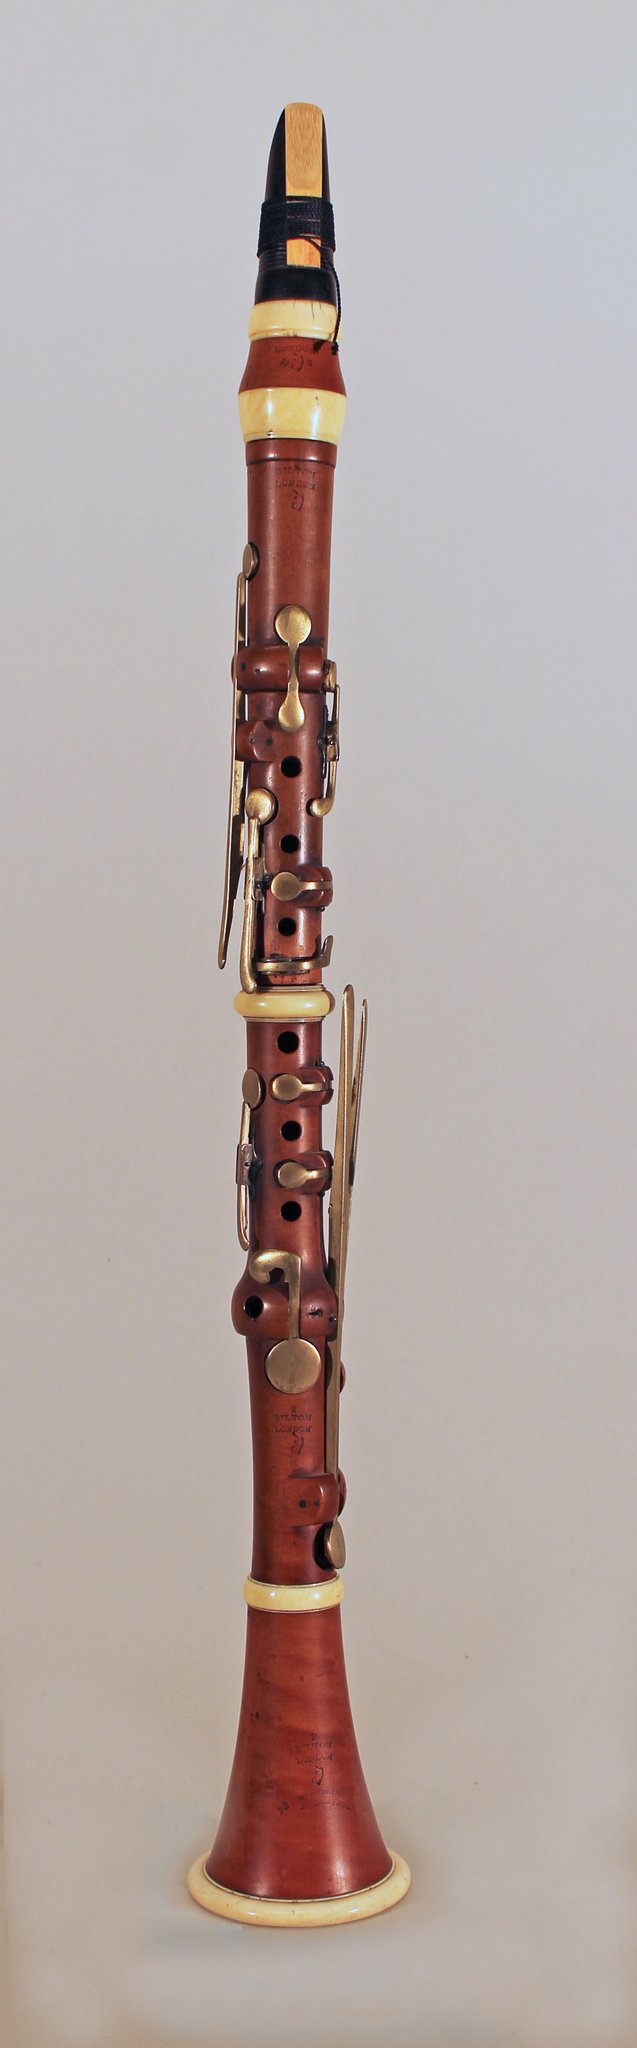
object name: clarinet in c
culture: british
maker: richard bilton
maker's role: maker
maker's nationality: british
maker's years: 1826-1856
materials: brass, ivory, wood